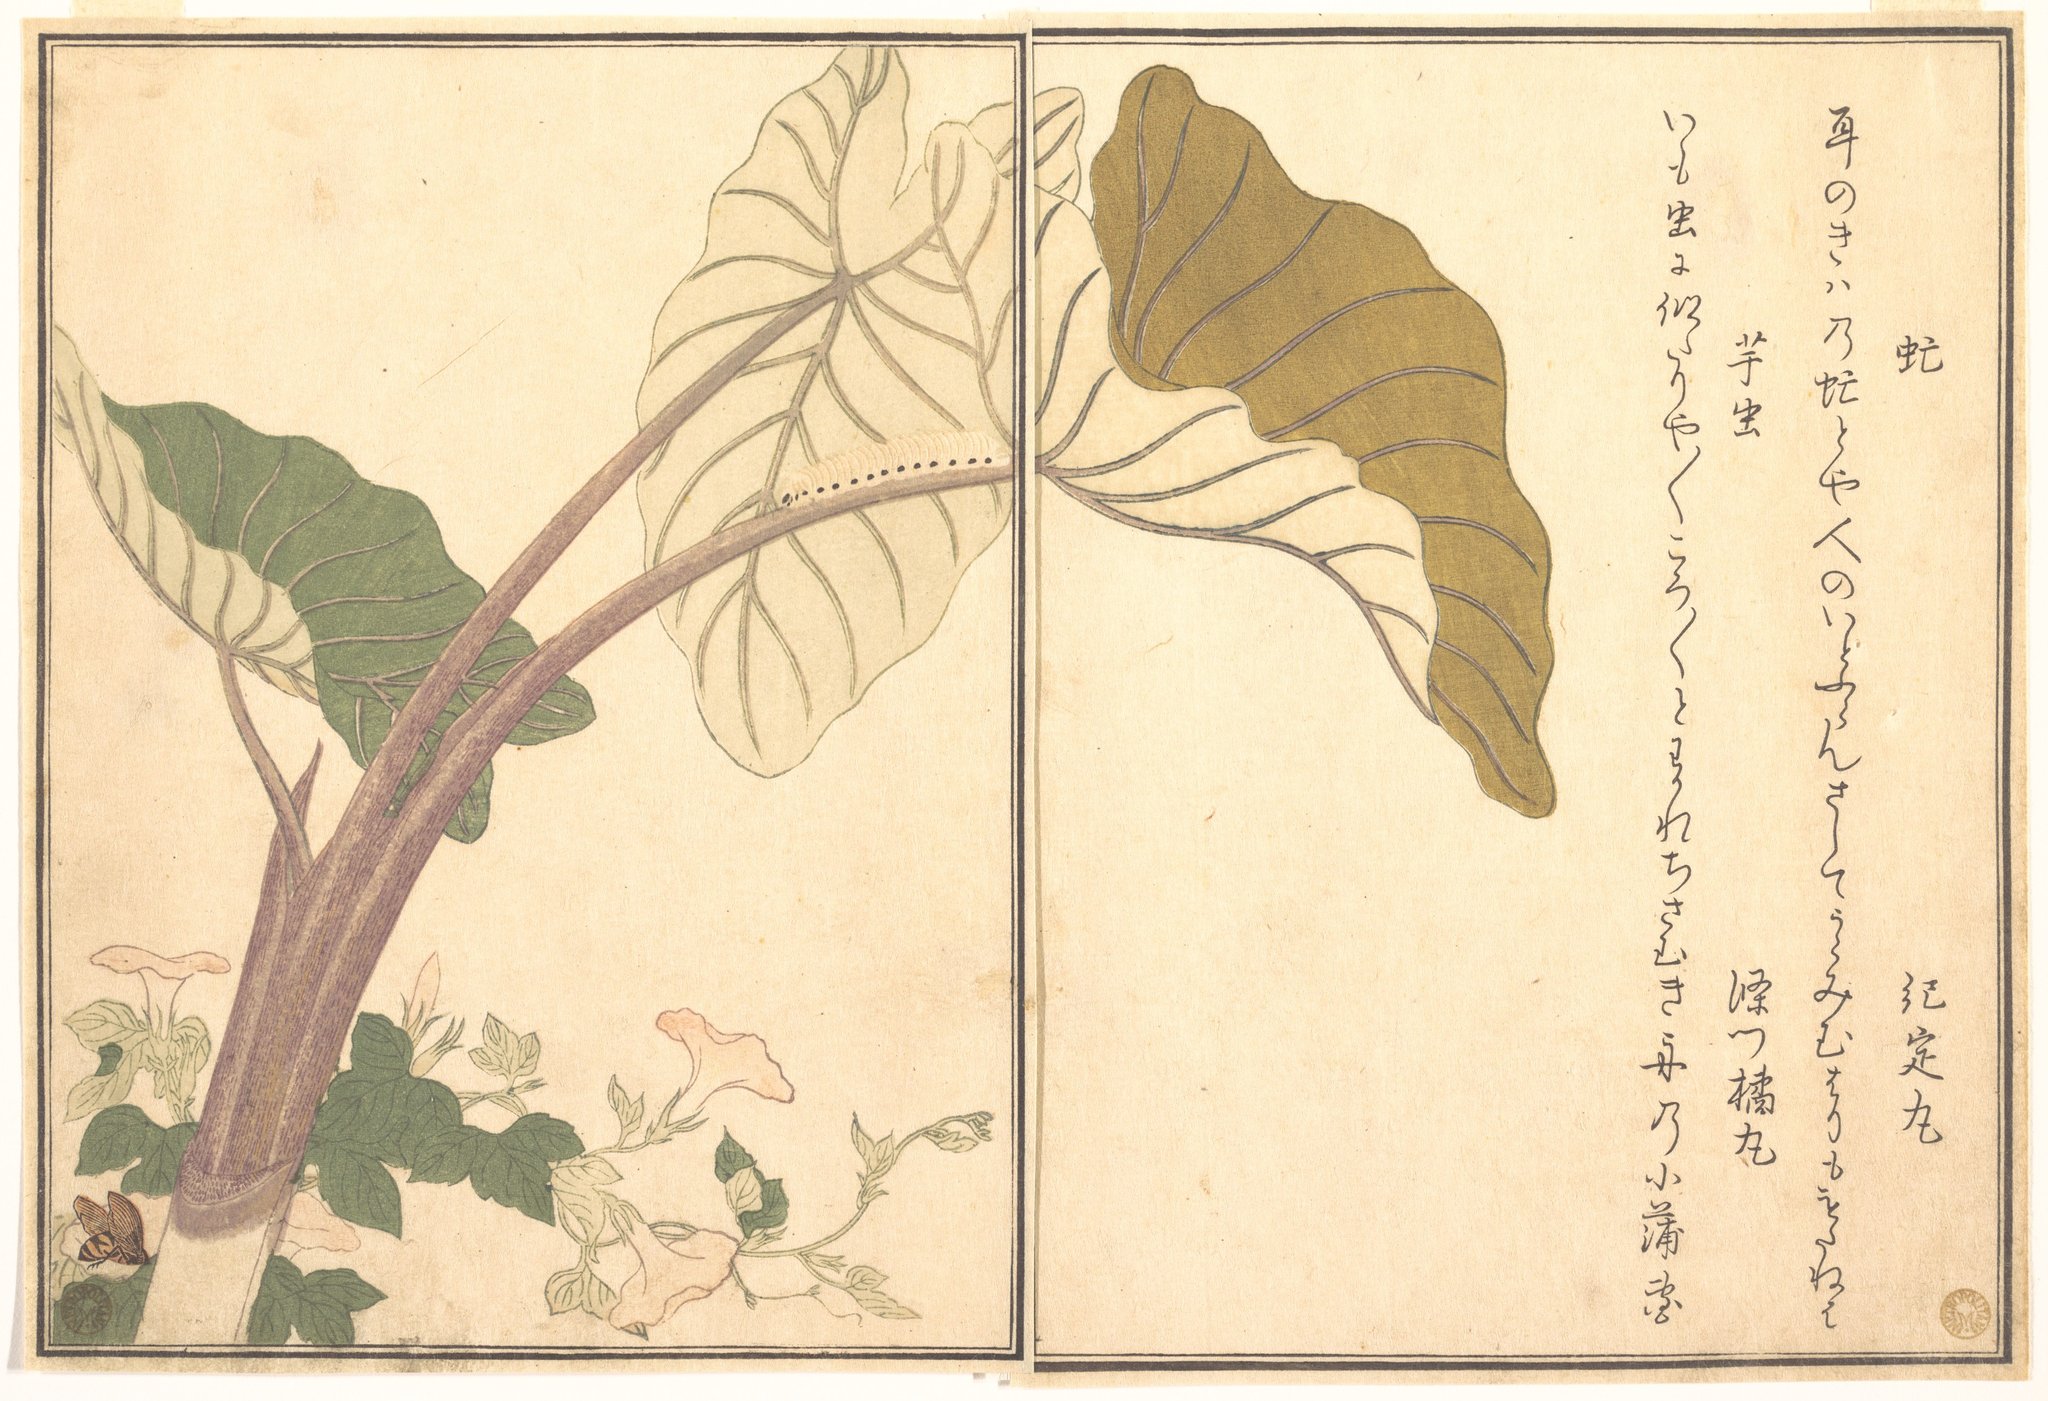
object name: woodblock print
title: Horsefly (abu); Green Caterpillar, imomushi, from the Picture Book of Crawling Creatures (Ehon mushi erami)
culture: japanese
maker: kitagawa utamaro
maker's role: artist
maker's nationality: japanese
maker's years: 1754-1806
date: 1788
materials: ink, paper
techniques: woodblock print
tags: flowers,leaves